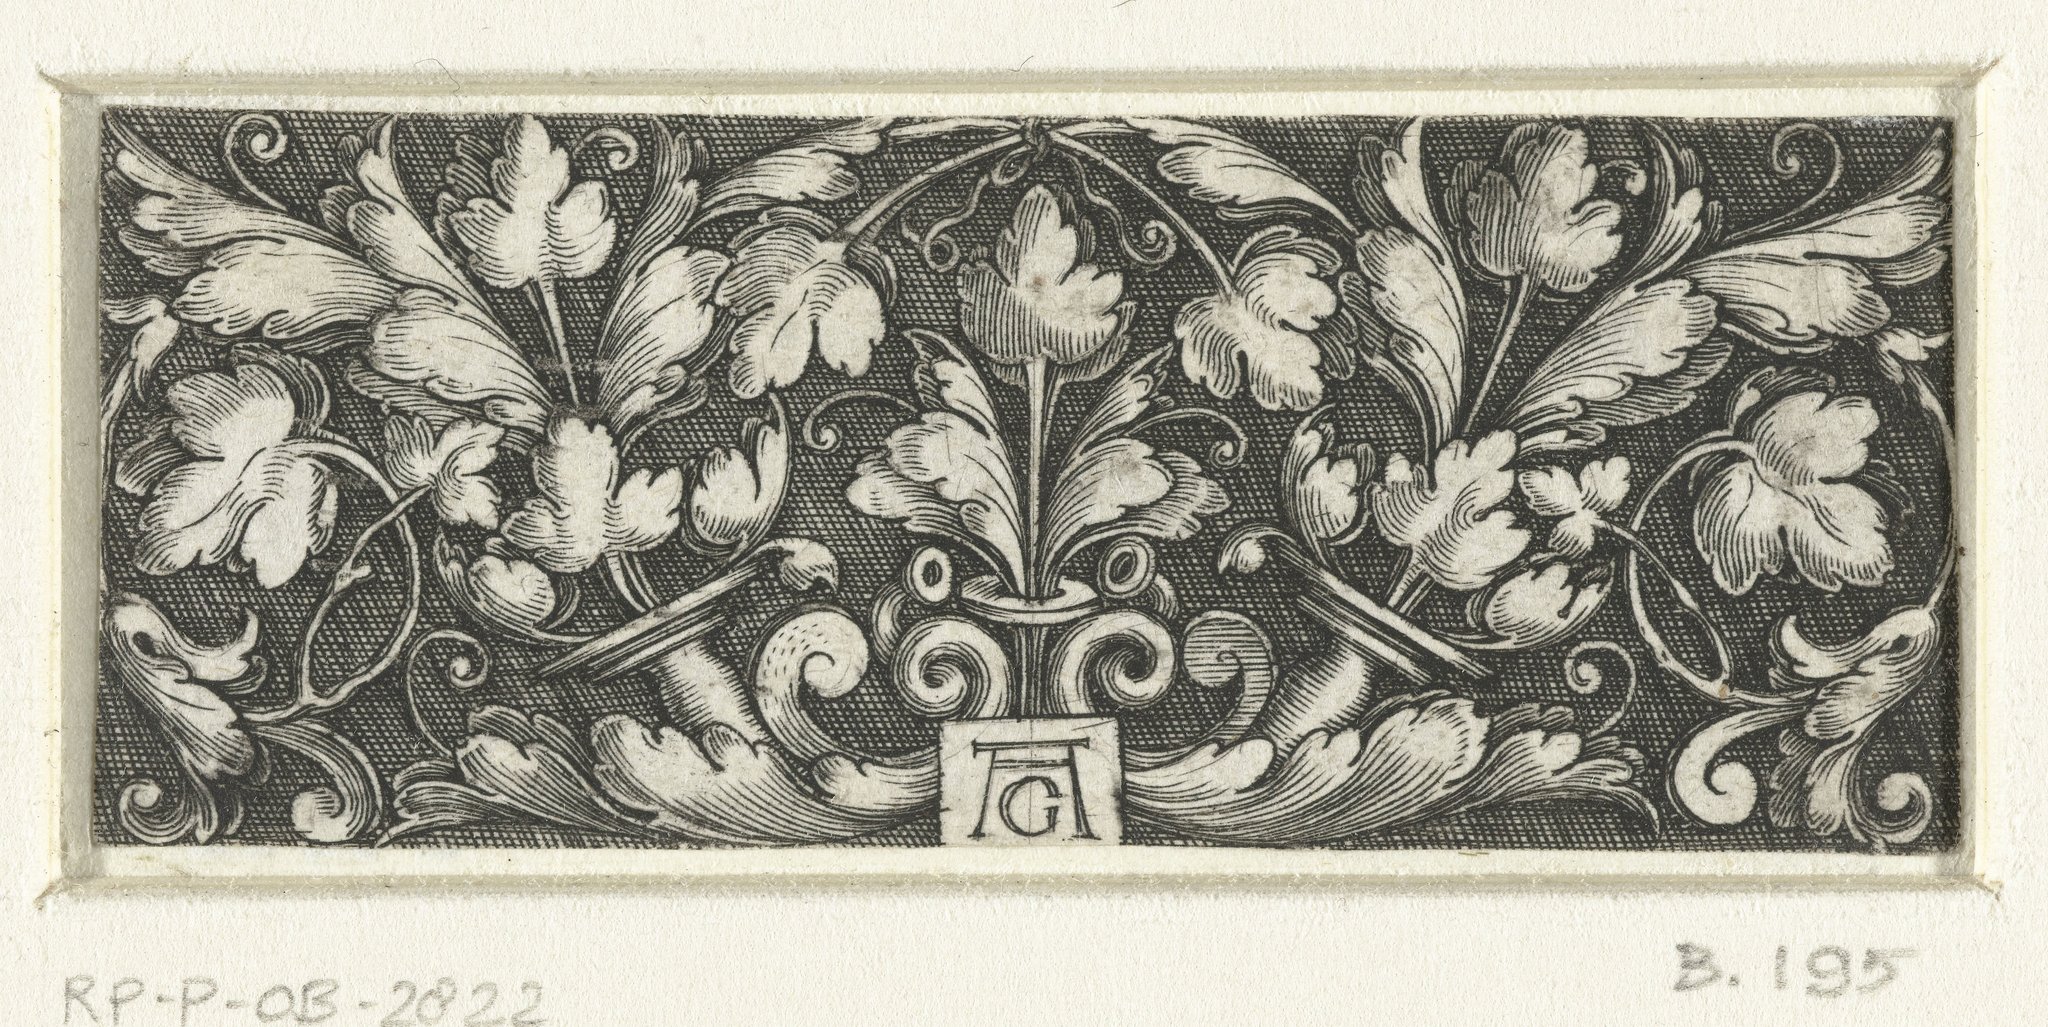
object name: print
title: Fries met bladranken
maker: heinrich aldegrever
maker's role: draughtsman, print maker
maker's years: 1502-1561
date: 1512-1560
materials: paper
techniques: engraving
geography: germany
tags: foliage, tendrils, branches ~ ornament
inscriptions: number: ‘9’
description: Fries met een boeketje van drie bladeren tussen bladranken.